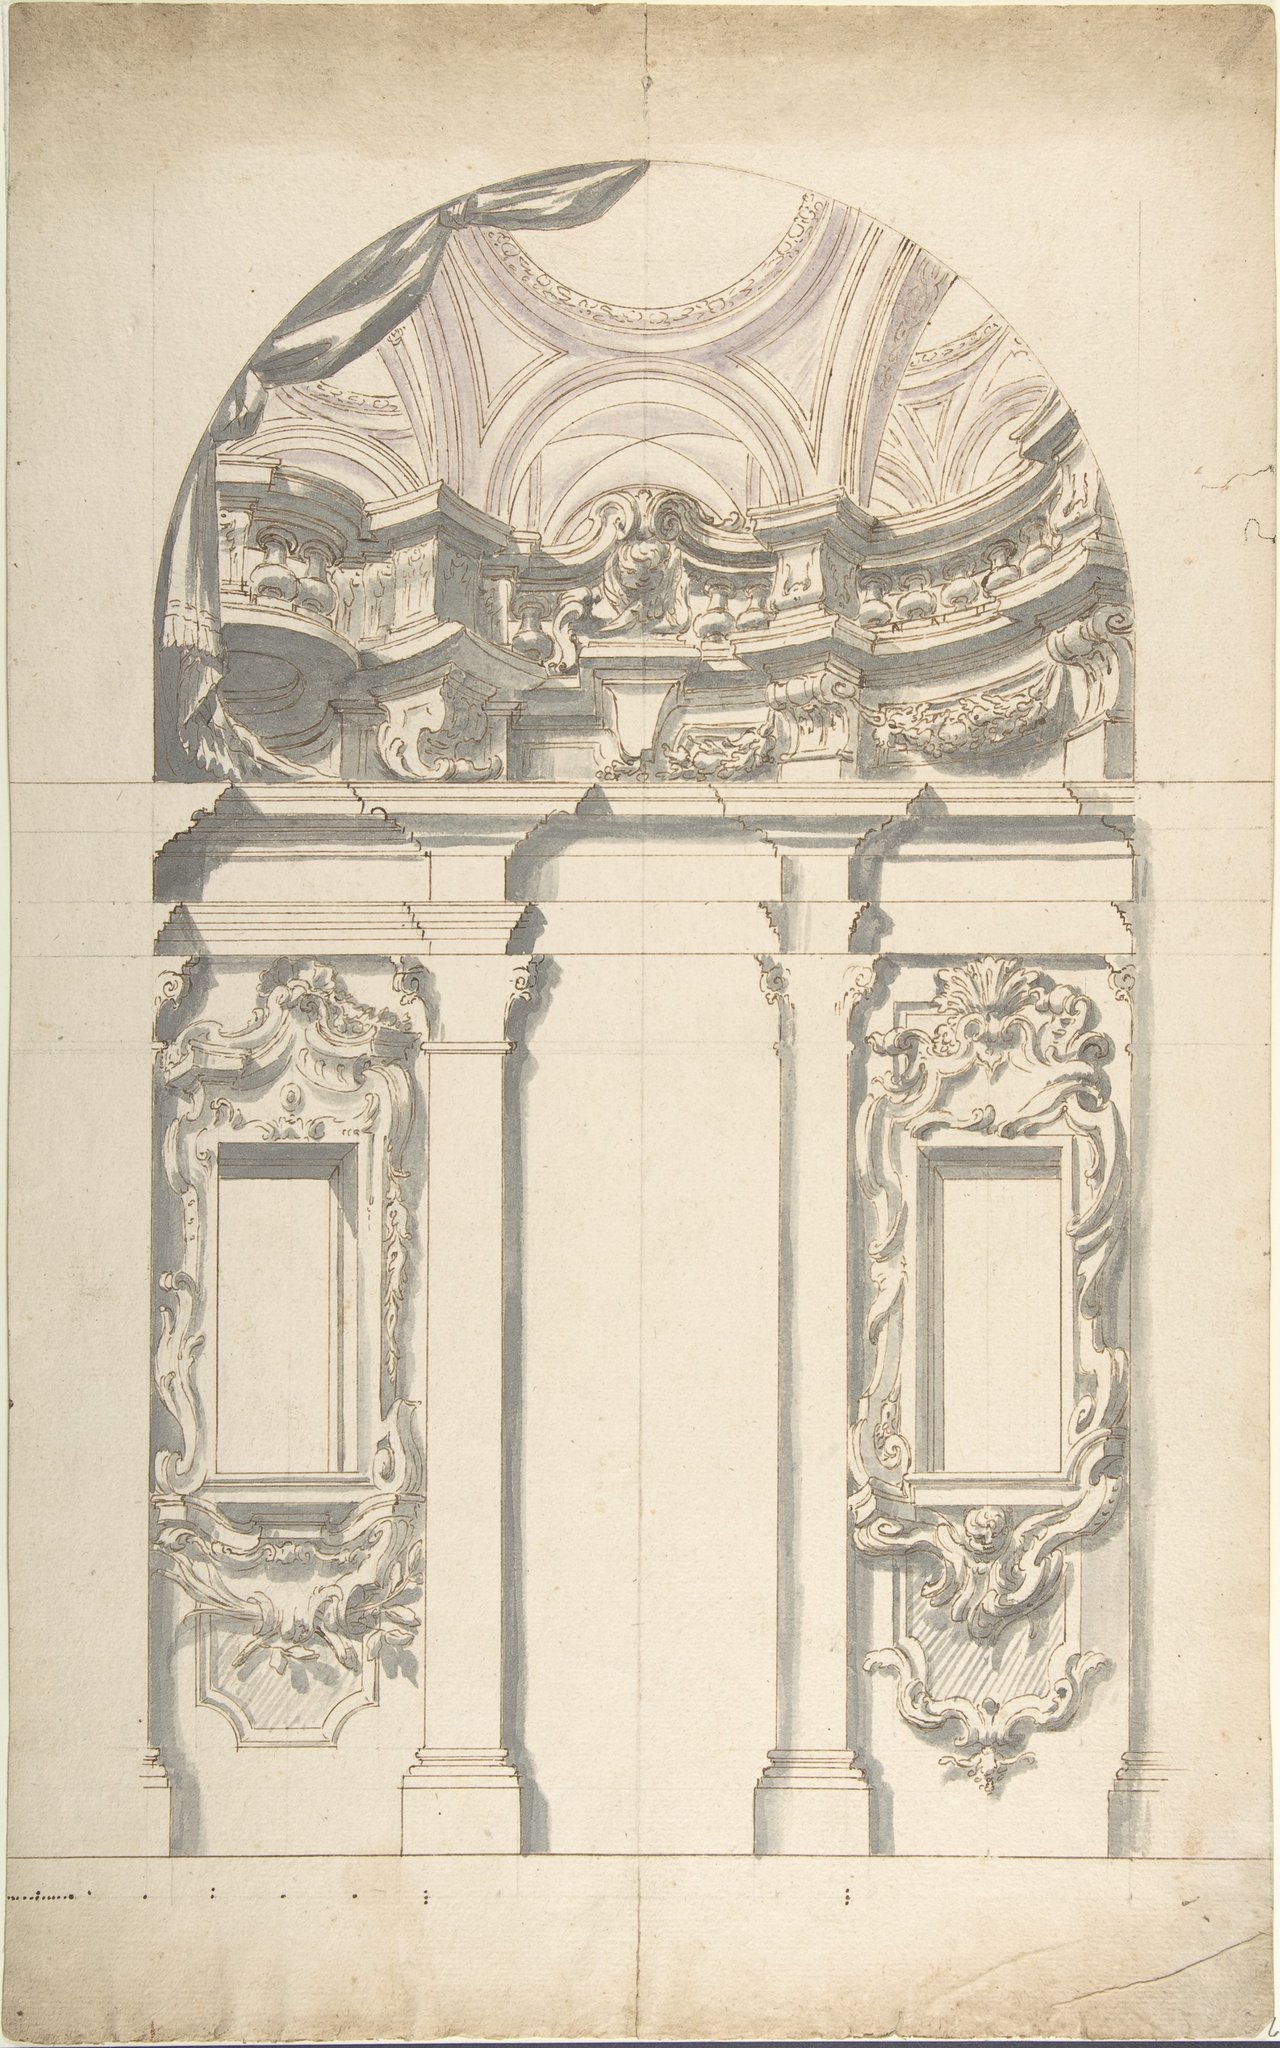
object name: drawing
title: Two alternate Design for a wall elevation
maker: anonymous, italian, piedmontese, 18th century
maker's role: artist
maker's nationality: italian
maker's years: 1700-1800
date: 1700-1780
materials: chalk, ink, drawing material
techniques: brush, pen, wash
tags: architecture